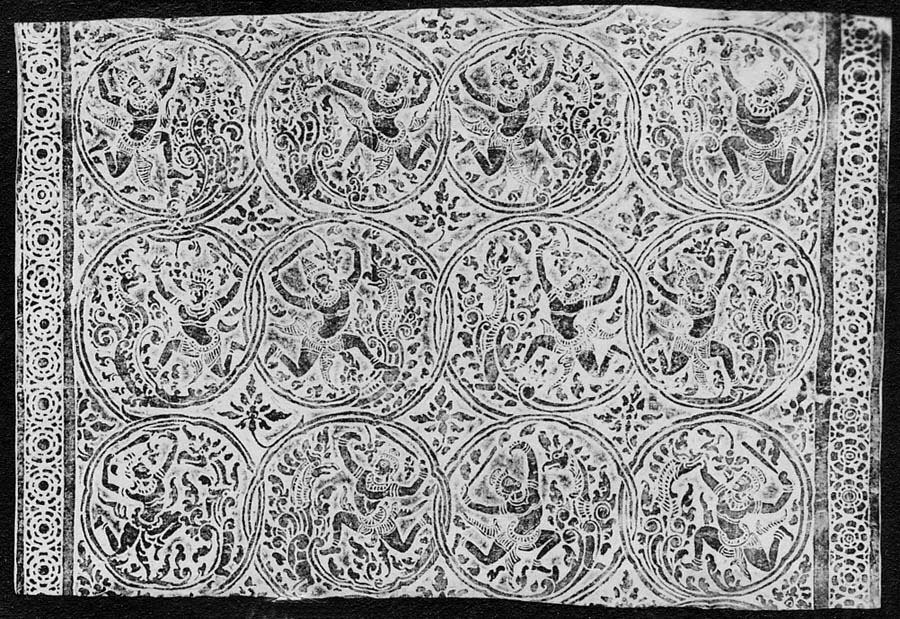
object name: rubbing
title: Rubbing of Apsarases (Dancers)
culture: cambodian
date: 1901-2000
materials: ink, paper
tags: human figures,dancers